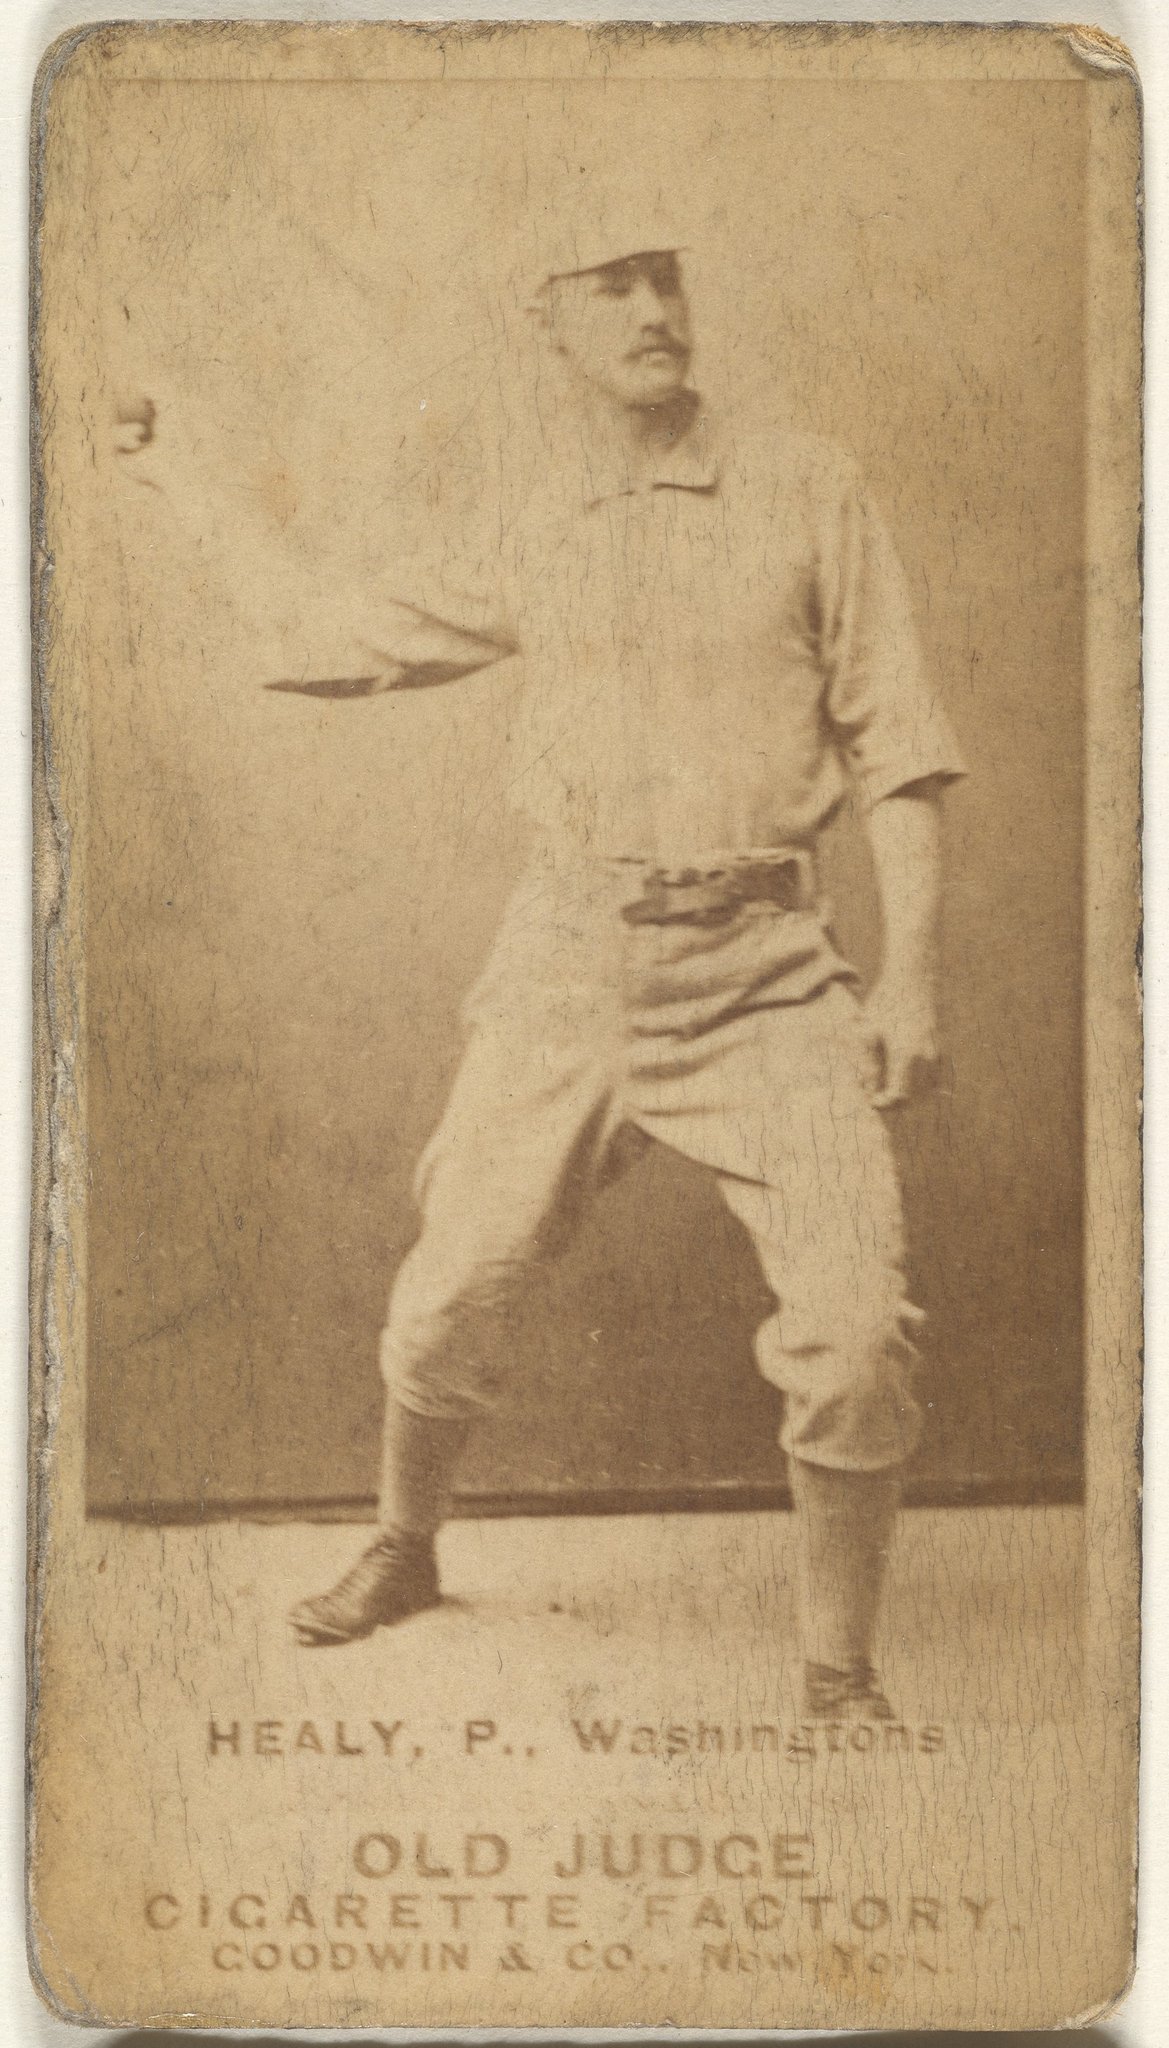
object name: baseball card, photograph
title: John J. "Egyptian" Healy, Pitcher, Washington Nationals, from the Old Judge series (N172) for Old Judge Cigarettes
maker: goodwin & company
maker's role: publisher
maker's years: 1850-1950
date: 1887-1890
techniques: albumen silver print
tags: men,portraits,baseball,athletes